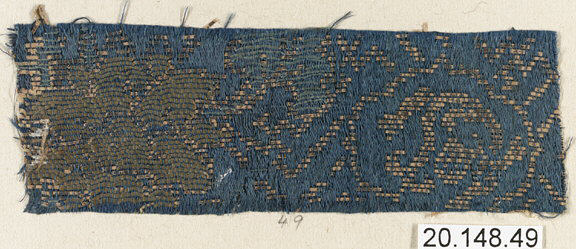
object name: piece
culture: japanese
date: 1601-1700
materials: silk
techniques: compound weave